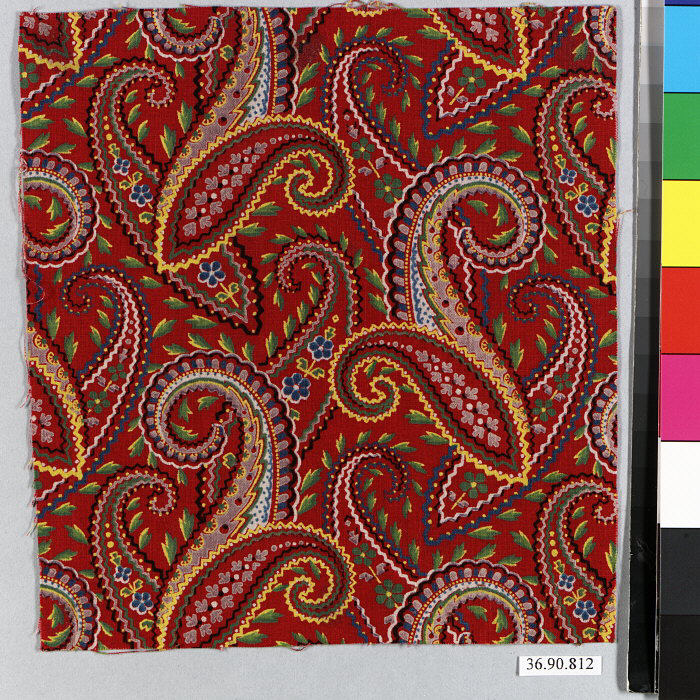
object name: piece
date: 1867-1900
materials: cotton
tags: flowers,leaves